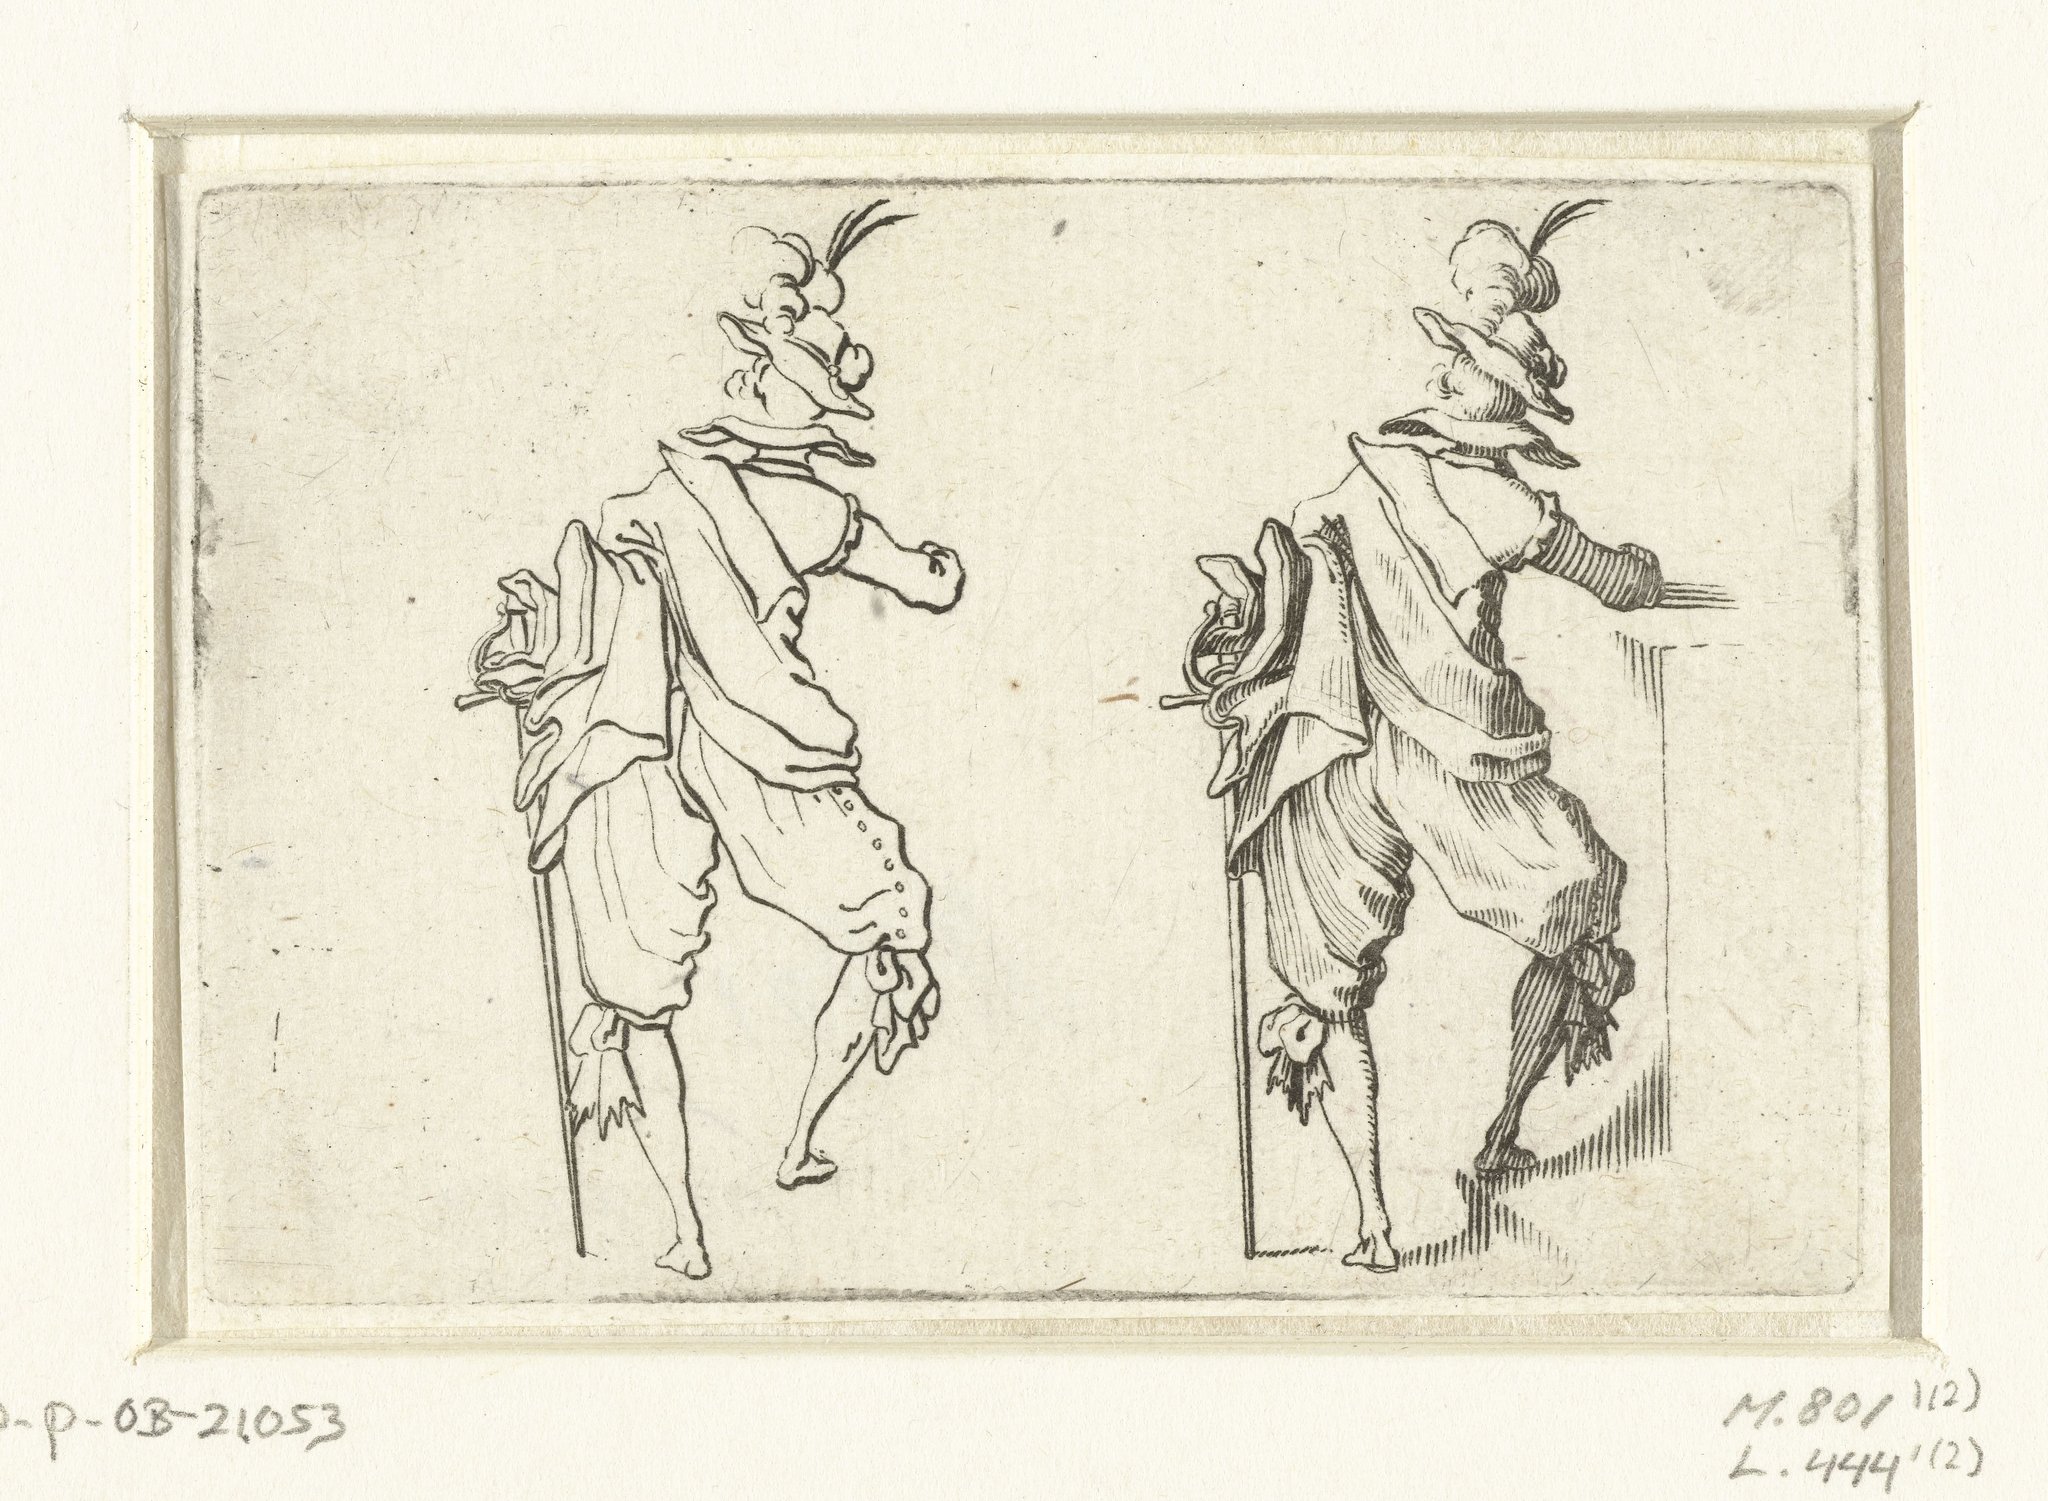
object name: print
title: Capricci di varie Figure di Jacopo Callot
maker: jacques callot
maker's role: draughtsman, print maker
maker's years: 1592-1635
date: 1621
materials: paper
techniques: etching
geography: nancy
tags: coat (+ men's clothes), head-gear: hat (+ men's clothes), hacking and thrusting weapons: sword, leaning sideways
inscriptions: collector's mark: Lugt 240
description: Een heer met een hoed op en een mantel over de linkerschouder, een zwaard in de linkerhand, met de rechterhand en -voet leunend op een muurtje, op de rug gezien, tweemaal afgebeeld: links als lijnfiguur, rechts meer uitgewerkt met schaduwpartijen. Deze prent is onderdeel van een serie van 48 prenten (50 incl. titelblad en dedicatieblad) met diverse onderwerpen (o.a. mannen en vrouwen in verschillende houdingen, landschappen, gebouwen en festiviteiten in Florence). Mogelijk zijn deze prenten bedoeld geweest als tekenvoorbeelden.